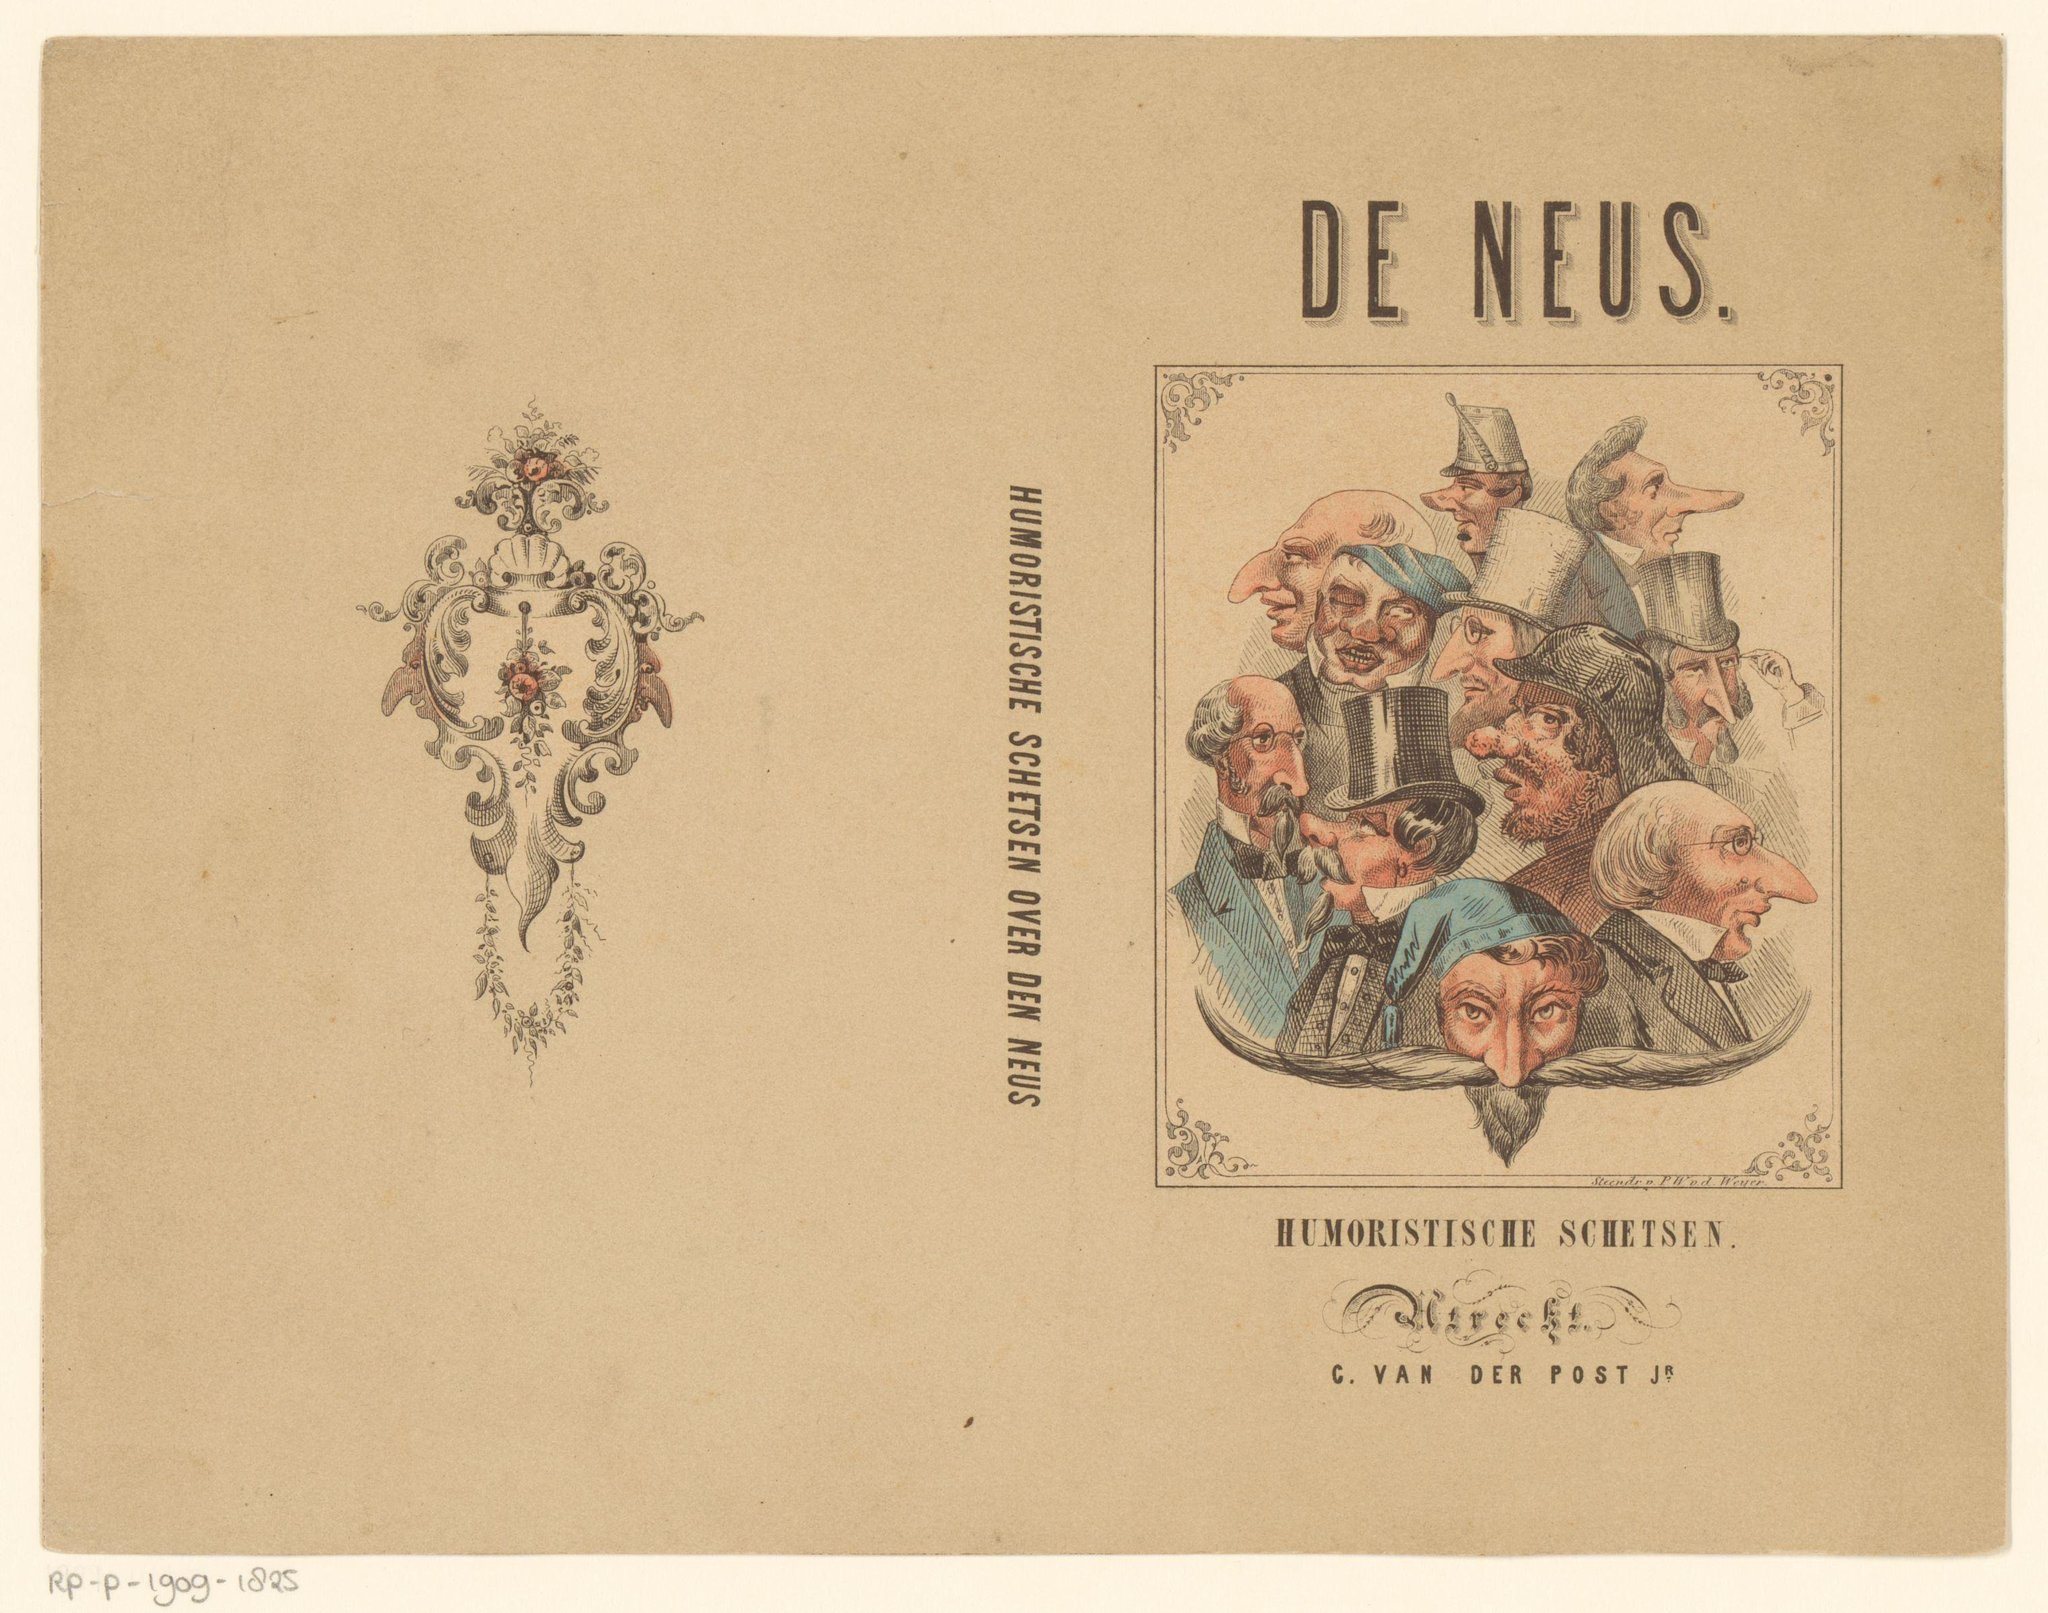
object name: titelprent, frontispice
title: Elf mannenhoofden met verschillende neuzen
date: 1842-1880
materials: paper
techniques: tone lithography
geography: utrecht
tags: caricatures (human types), parts of the face: nose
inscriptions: collector's mark: Lugt 2228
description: De koppen hebben allemaal een ander type neus. Links, de achterzijde van het omslag, een ornament met bloemen.